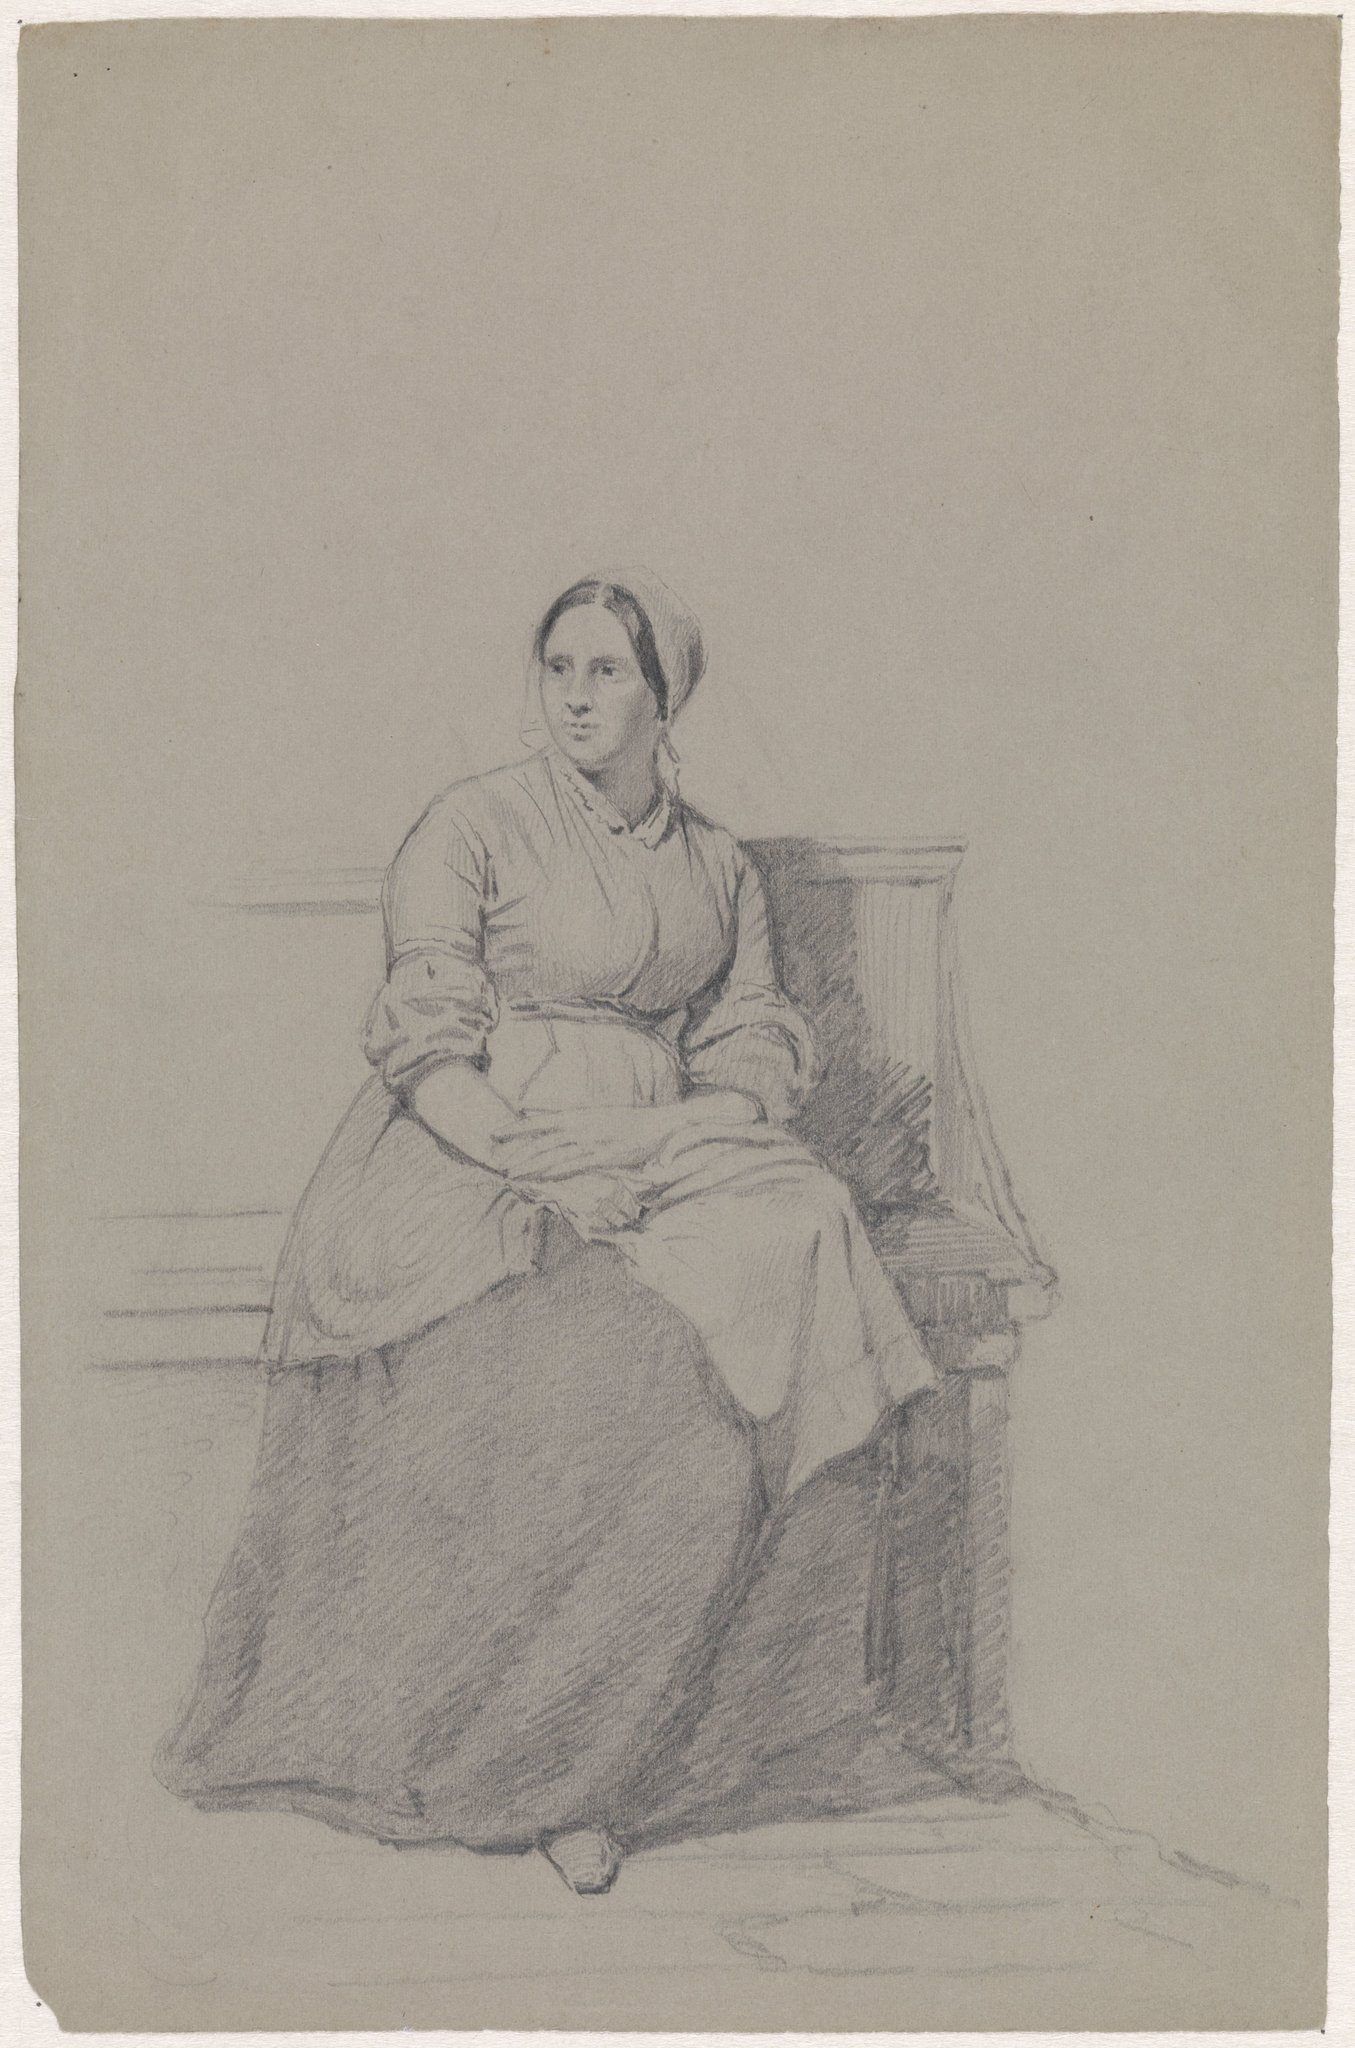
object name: drawing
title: Figuurstudie van een zittende vrouw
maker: adrianus eversen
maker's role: draughtsman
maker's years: 1818-1897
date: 1828-1897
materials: paper, pencil